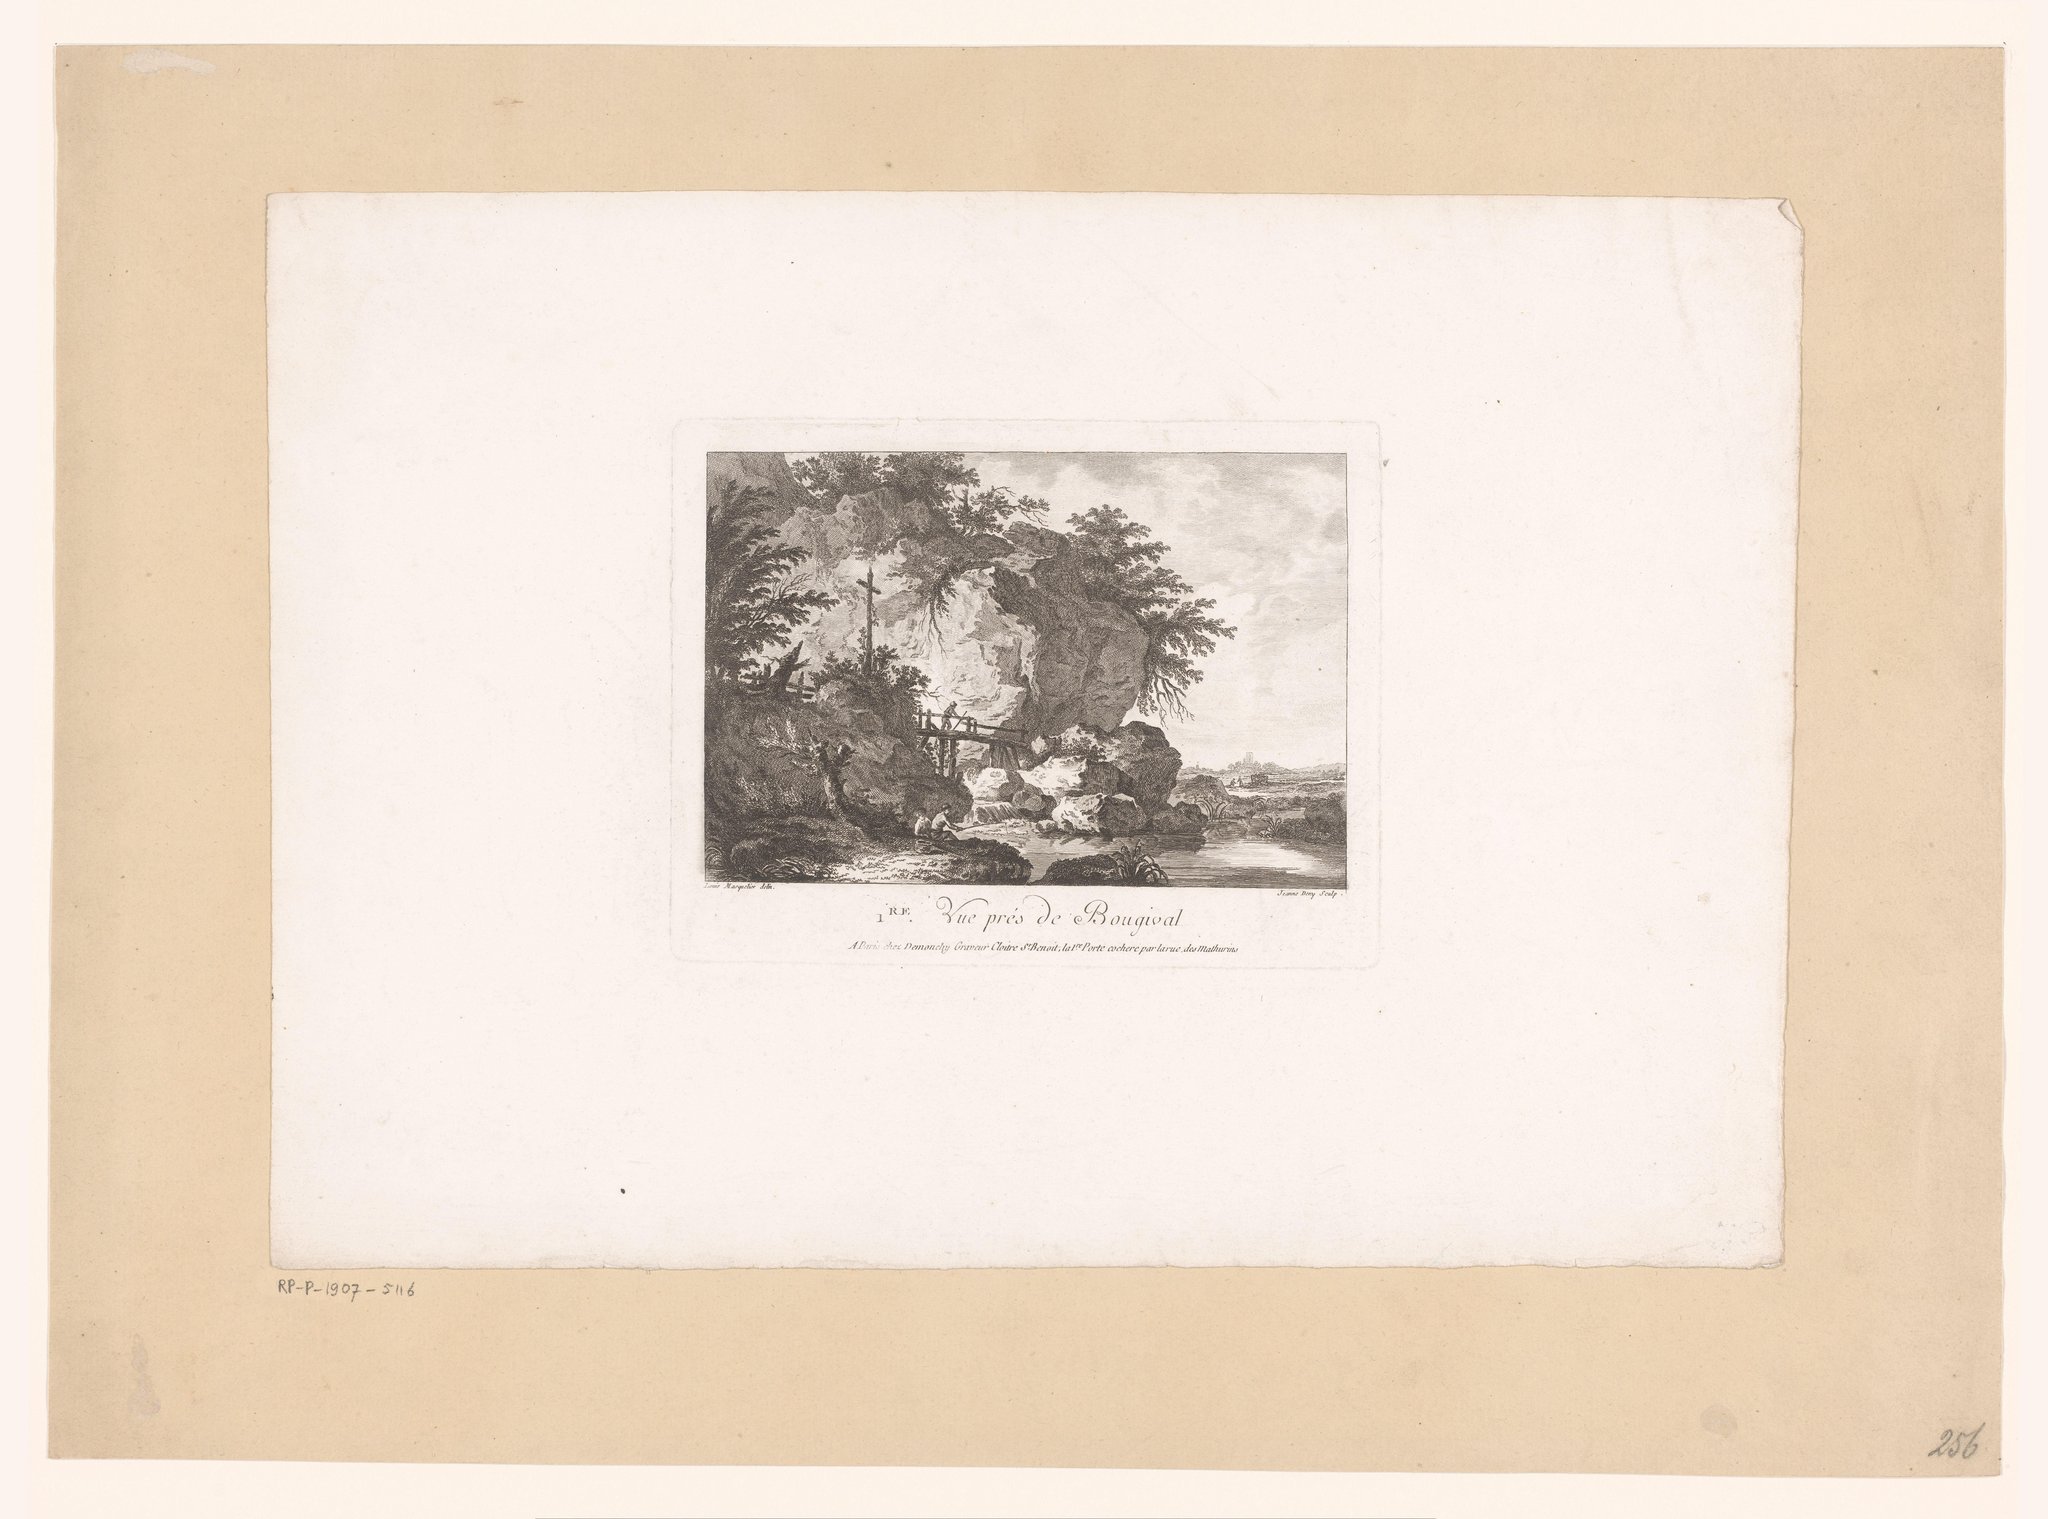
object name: print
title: 1Re Vue prés de Bougival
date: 1759-1815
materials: paper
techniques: etching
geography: france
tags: landscapes, landscape with bridge, viaduct or aqueduct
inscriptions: collector's mark: Lugt 2228